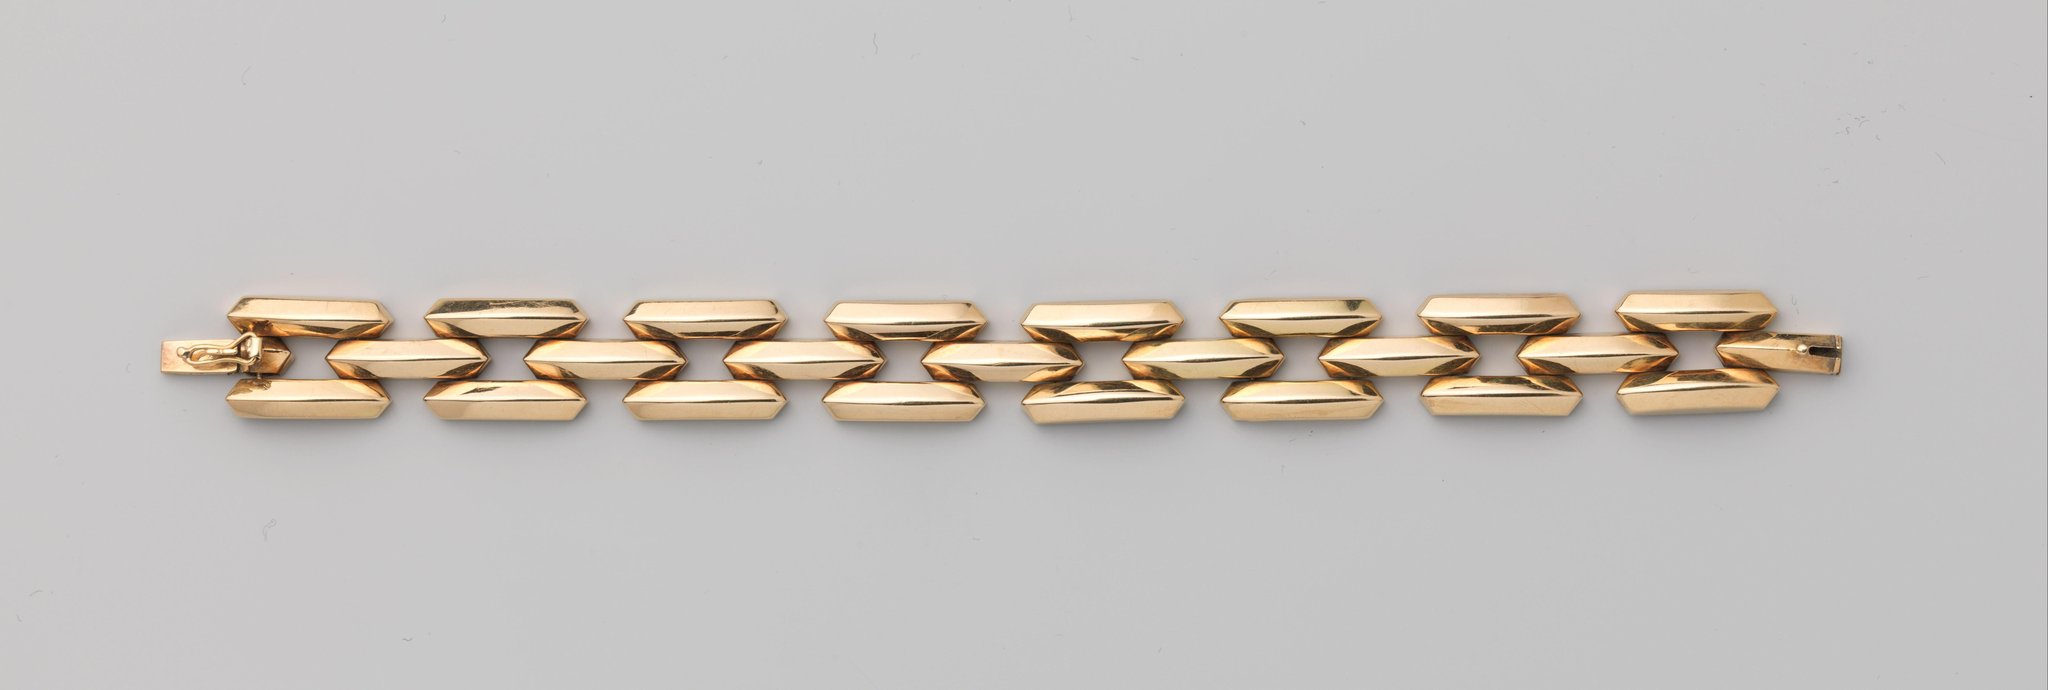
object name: chain bracelet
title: Schakelarmband van goud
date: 1940-1950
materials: gold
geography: voorschoten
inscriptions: maker's mark: ‘DCW’, alloy mark: ‘eikenblad 585’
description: Schakelarmband van goud met rechthoekige in het midden gesnoerde schakels voorzien van een bakslot en een veiligheidsachtje.